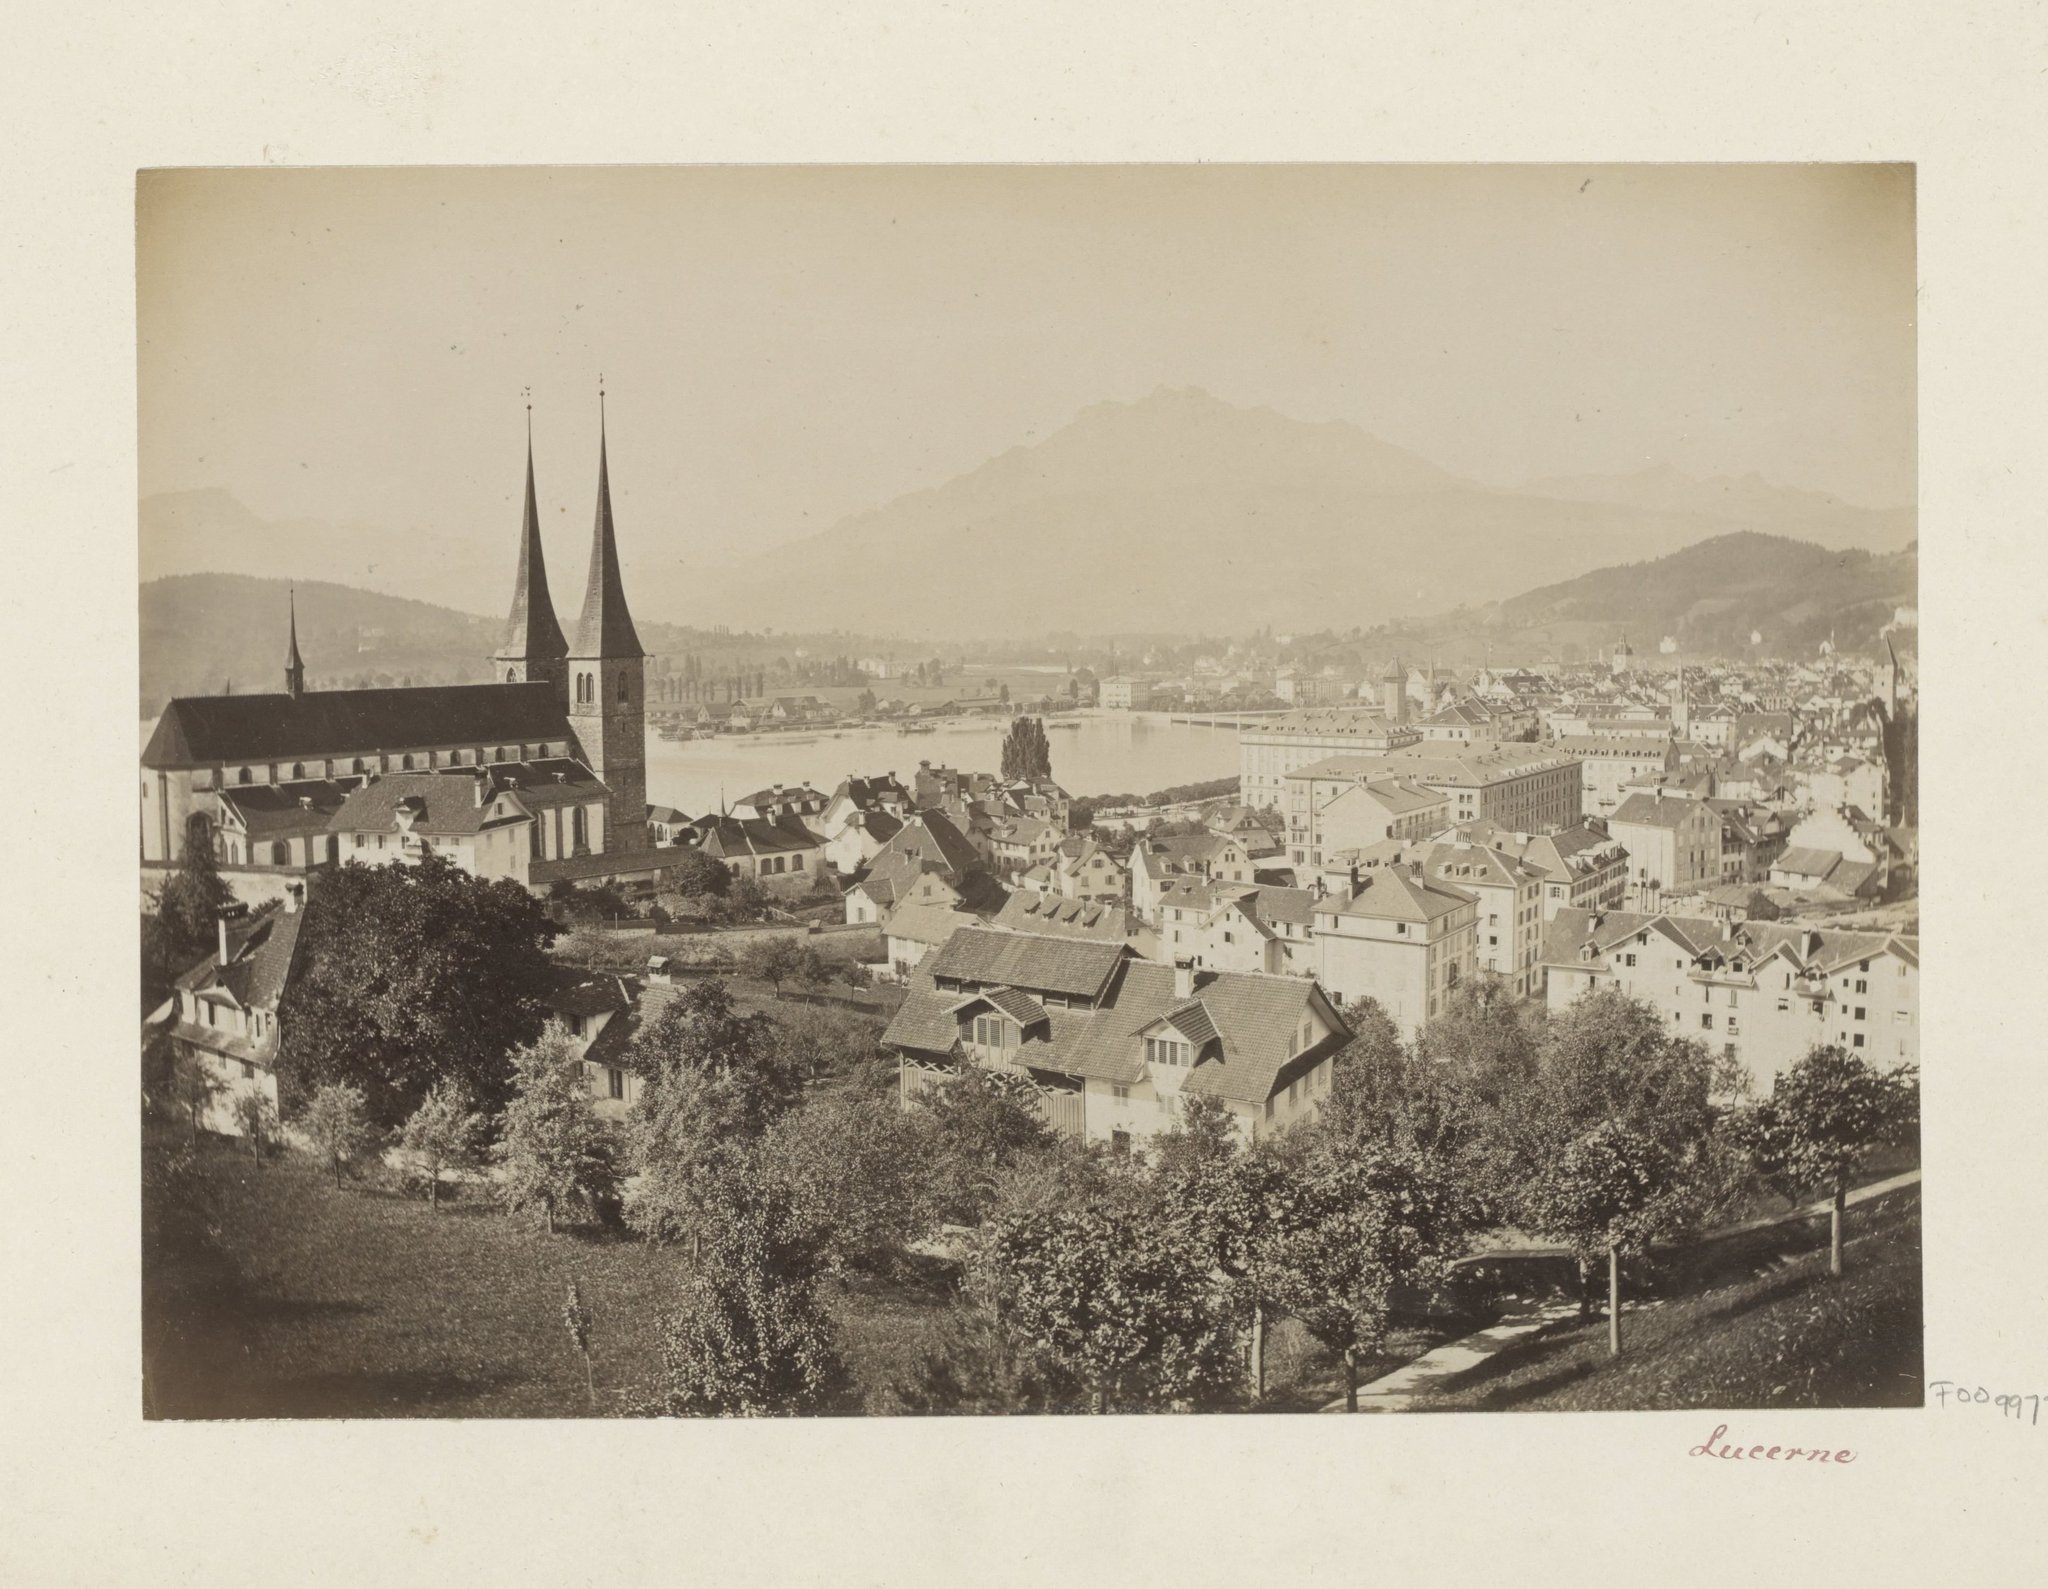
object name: photograph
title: Gezicht op Luzern met op de voorgrond de kerk van Sint Leodegar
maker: Anonymous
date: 1860-1890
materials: paper, photographic support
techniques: albumen print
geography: lucerne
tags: church (exterior), prospect of city, town panorama, silhouette of city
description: Onderdeel van Reisalbum met foto's van Zwitserland, Oostenrijk, Italië en Duitsland.